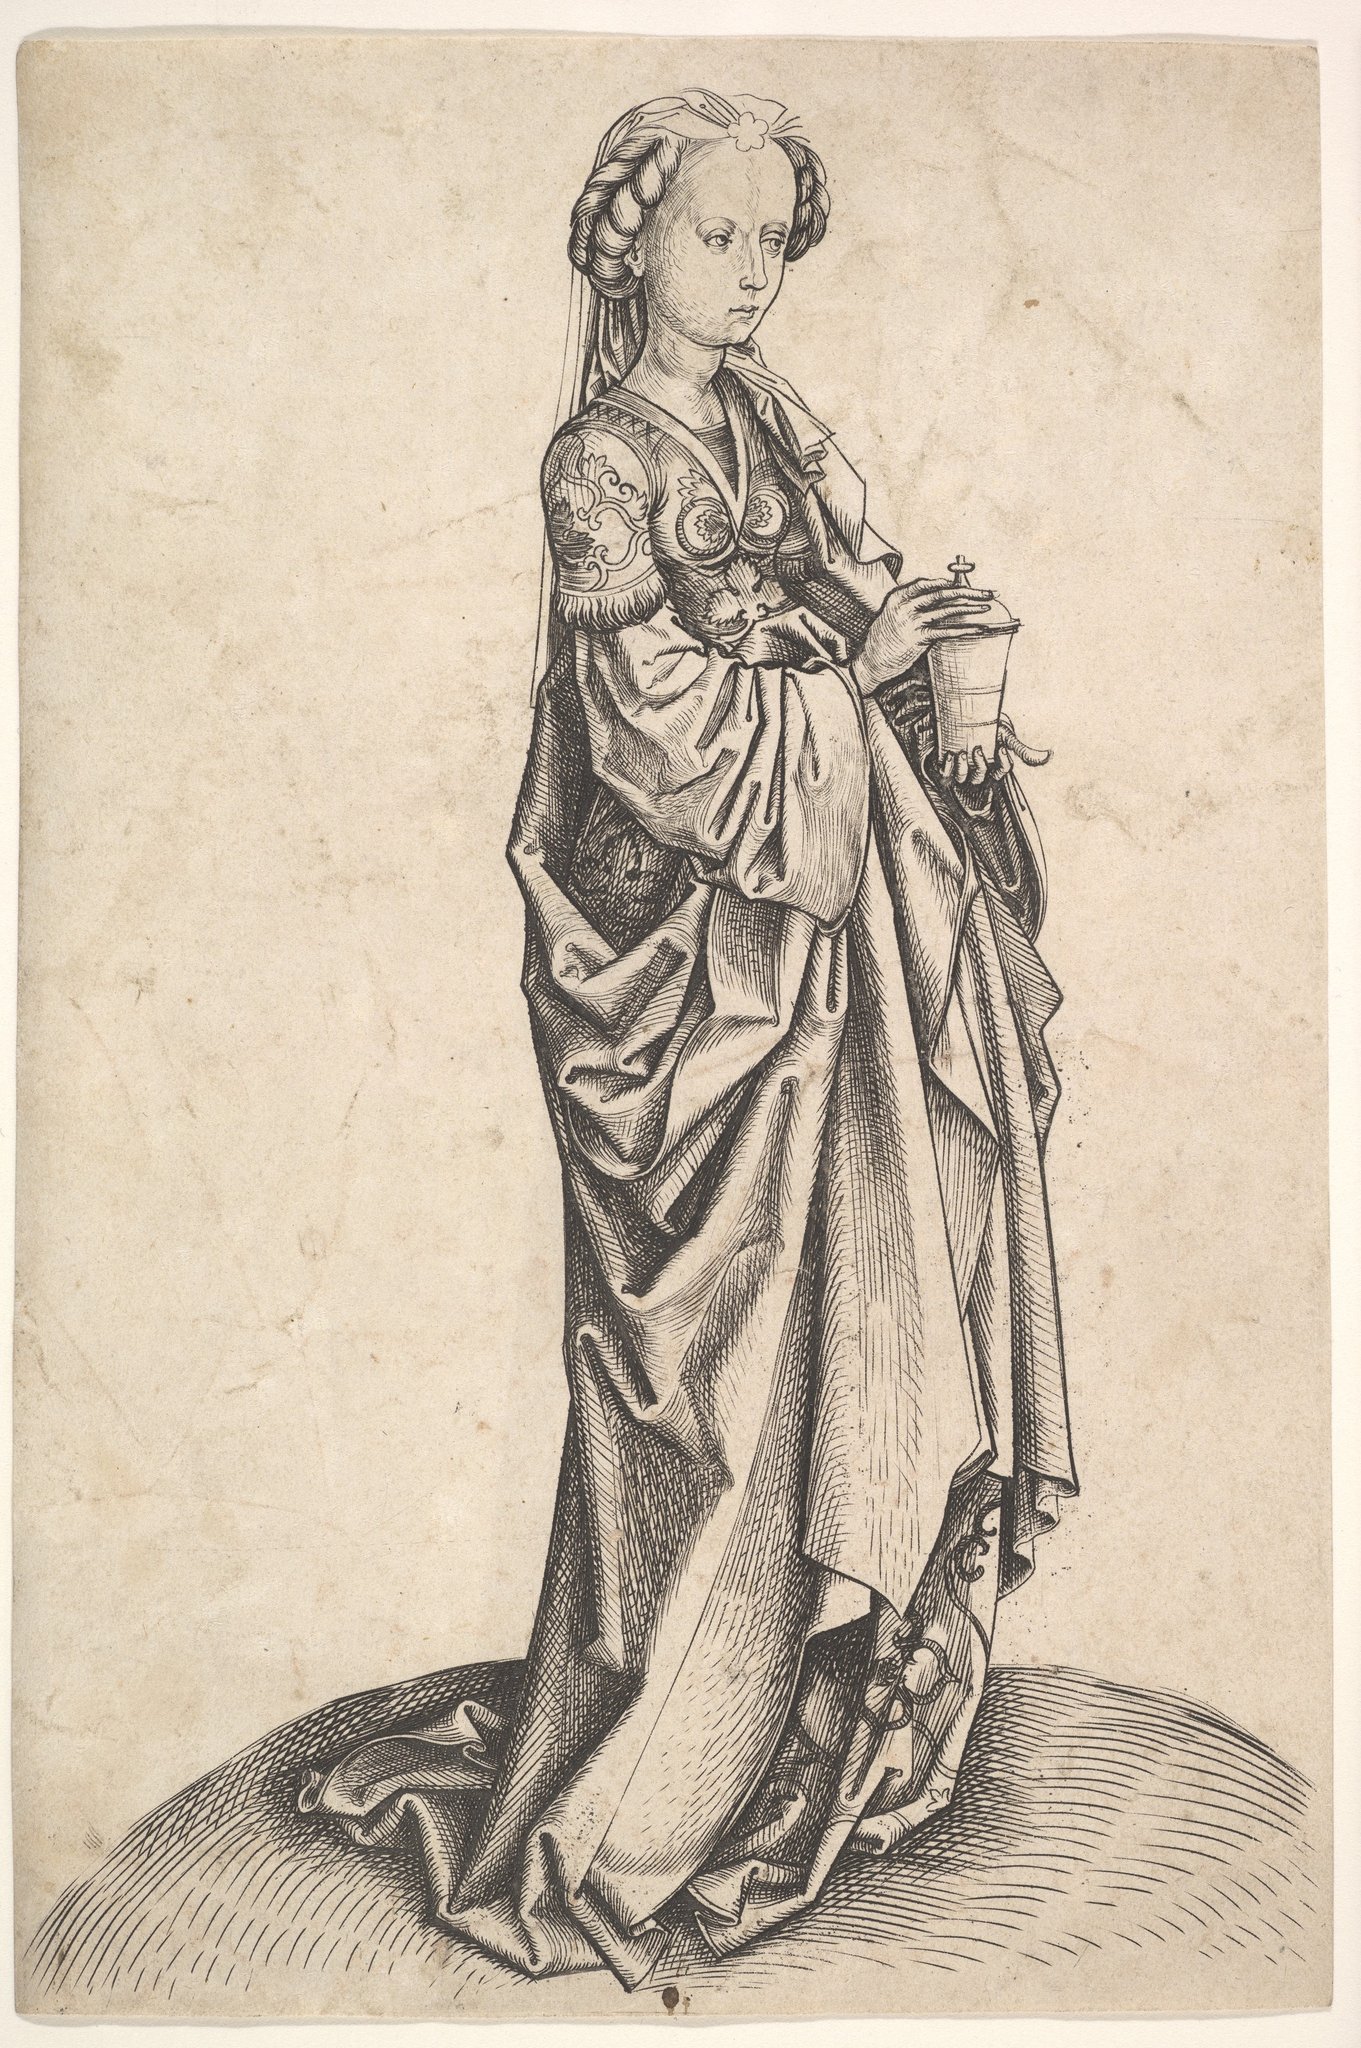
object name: print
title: Mary Magdalen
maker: master i.e.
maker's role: artist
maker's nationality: german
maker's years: 1450-1500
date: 1490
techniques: engraving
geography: germany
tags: mary magdalene